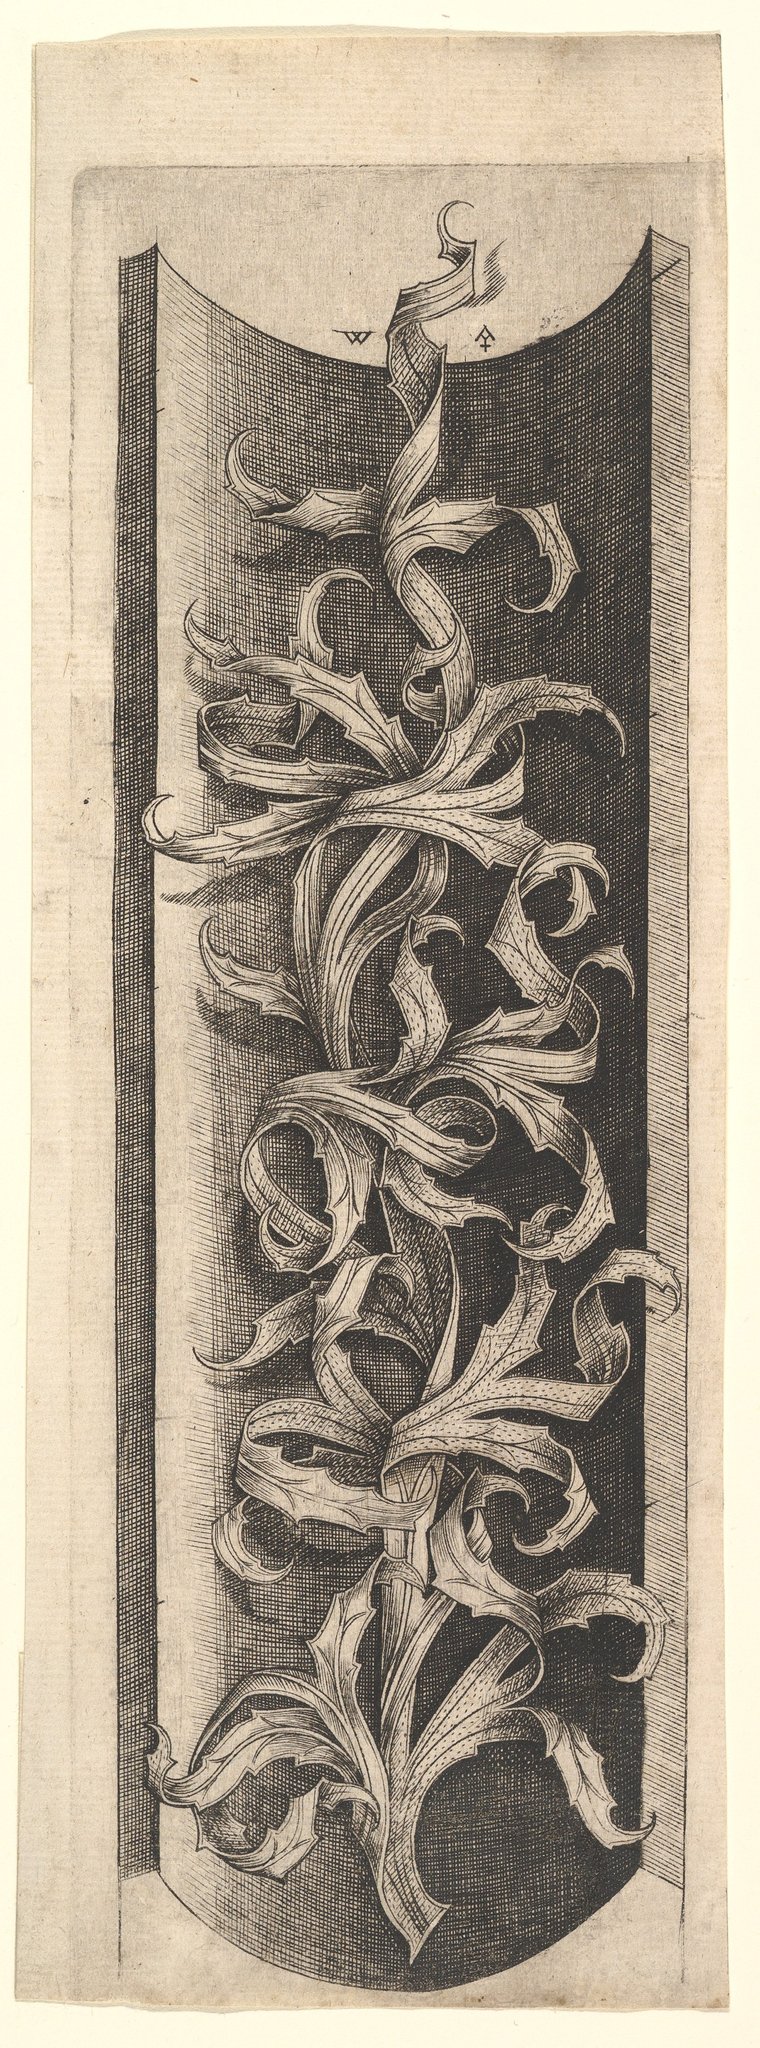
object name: print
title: Foliate Ornament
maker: master w with key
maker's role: artist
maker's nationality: netherlandish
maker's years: 1465-1490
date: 1465-1490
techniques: engraving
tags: ornament,leaves